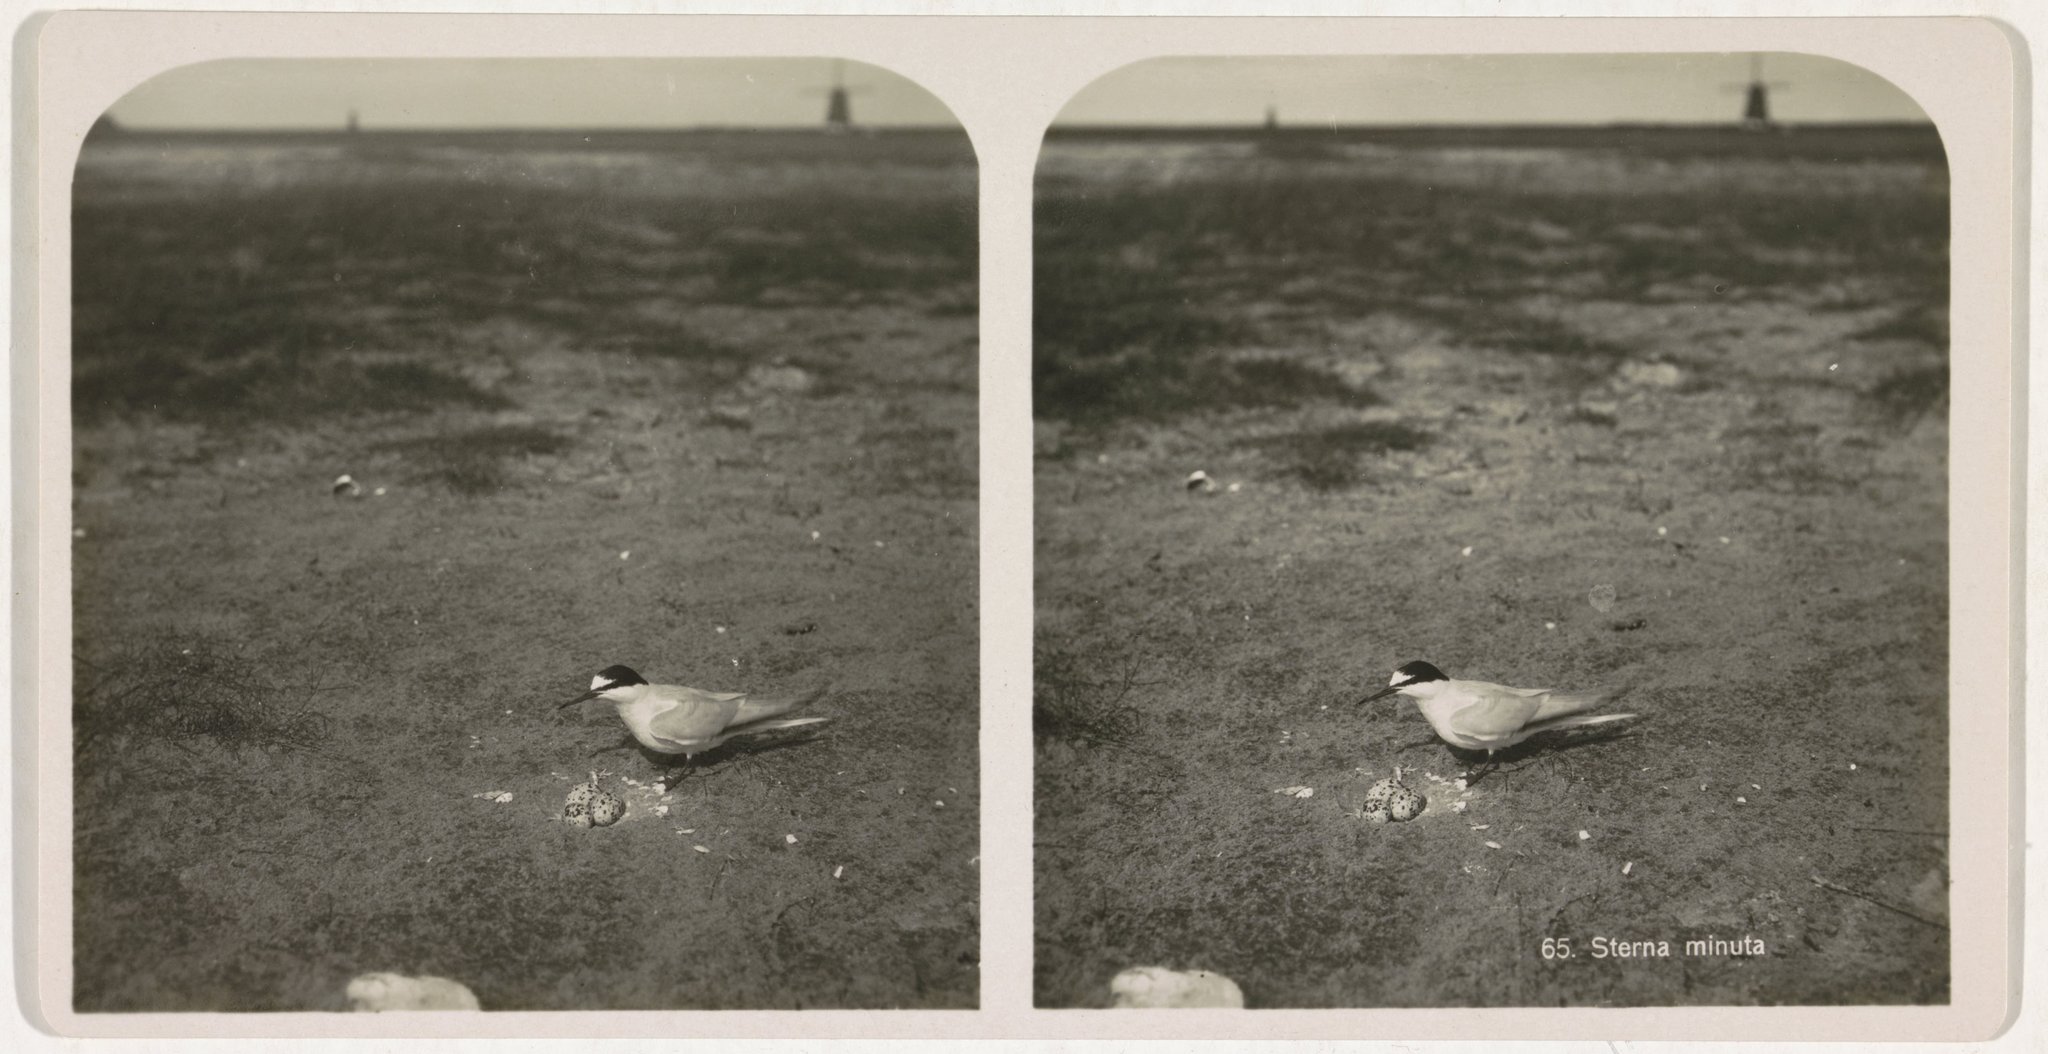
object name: stereograph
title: Kleine zee-zwaluw bij nest met drie eieren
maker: adolphe burdet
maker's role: fotograaf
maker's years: 1860-1940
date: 1870-1940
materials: photographic support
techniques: gelatin silver print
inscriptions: label: ‘Zee-Zwaluw’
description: De foto maakt deel uit van een serie van 12 stereofoto's, bewaard in het originele mapje. De foto's tonen zeevogels in natuurgebied De Bol op Texel.